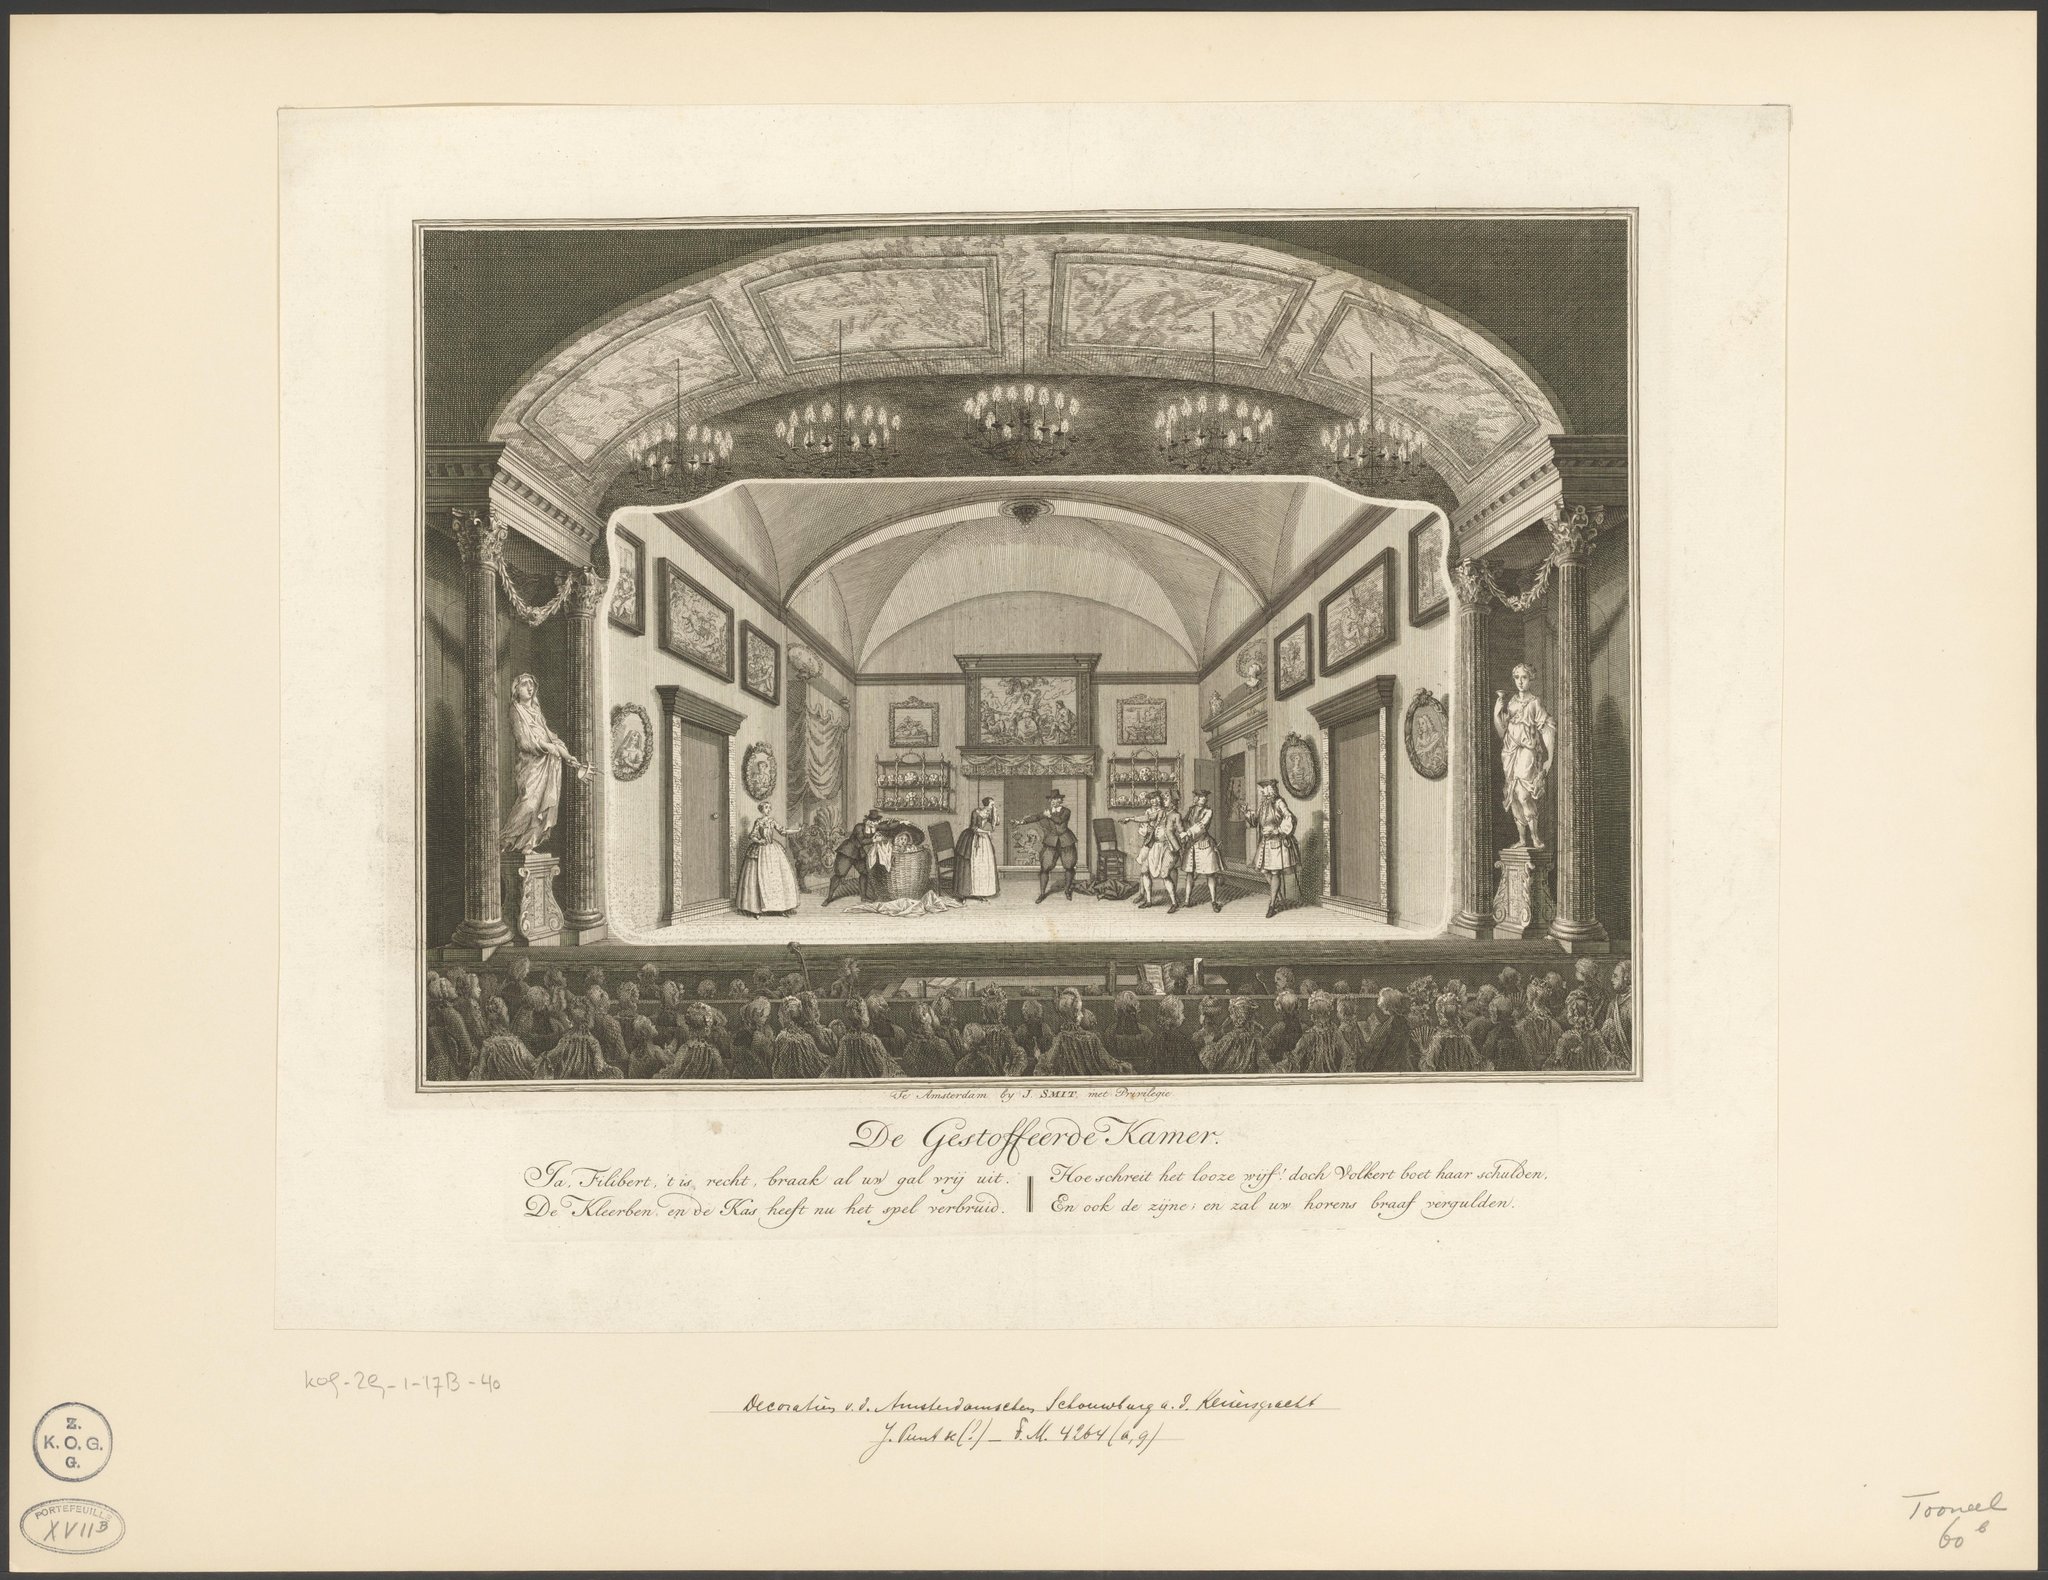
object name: print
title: Toneeldecors van de Amsterdamse Schouwburg, ca. 1770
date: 1736-1738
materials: paper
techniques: engraving, etching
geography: amsterdam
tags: theatre, theatrical performance, stage design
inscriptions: collector's mark: Lugt 1641, stamp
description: Toneelvoorstelling in de Amsterdamse Schouwburg op de Keizersgracht met het coulissendecor De Gestoffeerde Kamer met scène uit: De ontdekte schyndeugd. Het decor gedrukt van een aparte plaat binnen een nieuw passe-partout met de zaal, orkestbak en de façade van het toneel met zuilen en kroonluchters. De titel en een vierregelig vers ook gedrukt van een aparte plaat. Onderdeel van een latere uitgave van de serie van twaalf toneeldecors. Onderwerpsrubrieken binnen de Atlas Zeden en Gewoonten: Schoone kunsten, Tooneel, Schouwburg op de Keizersgracht (1637 – 1772).